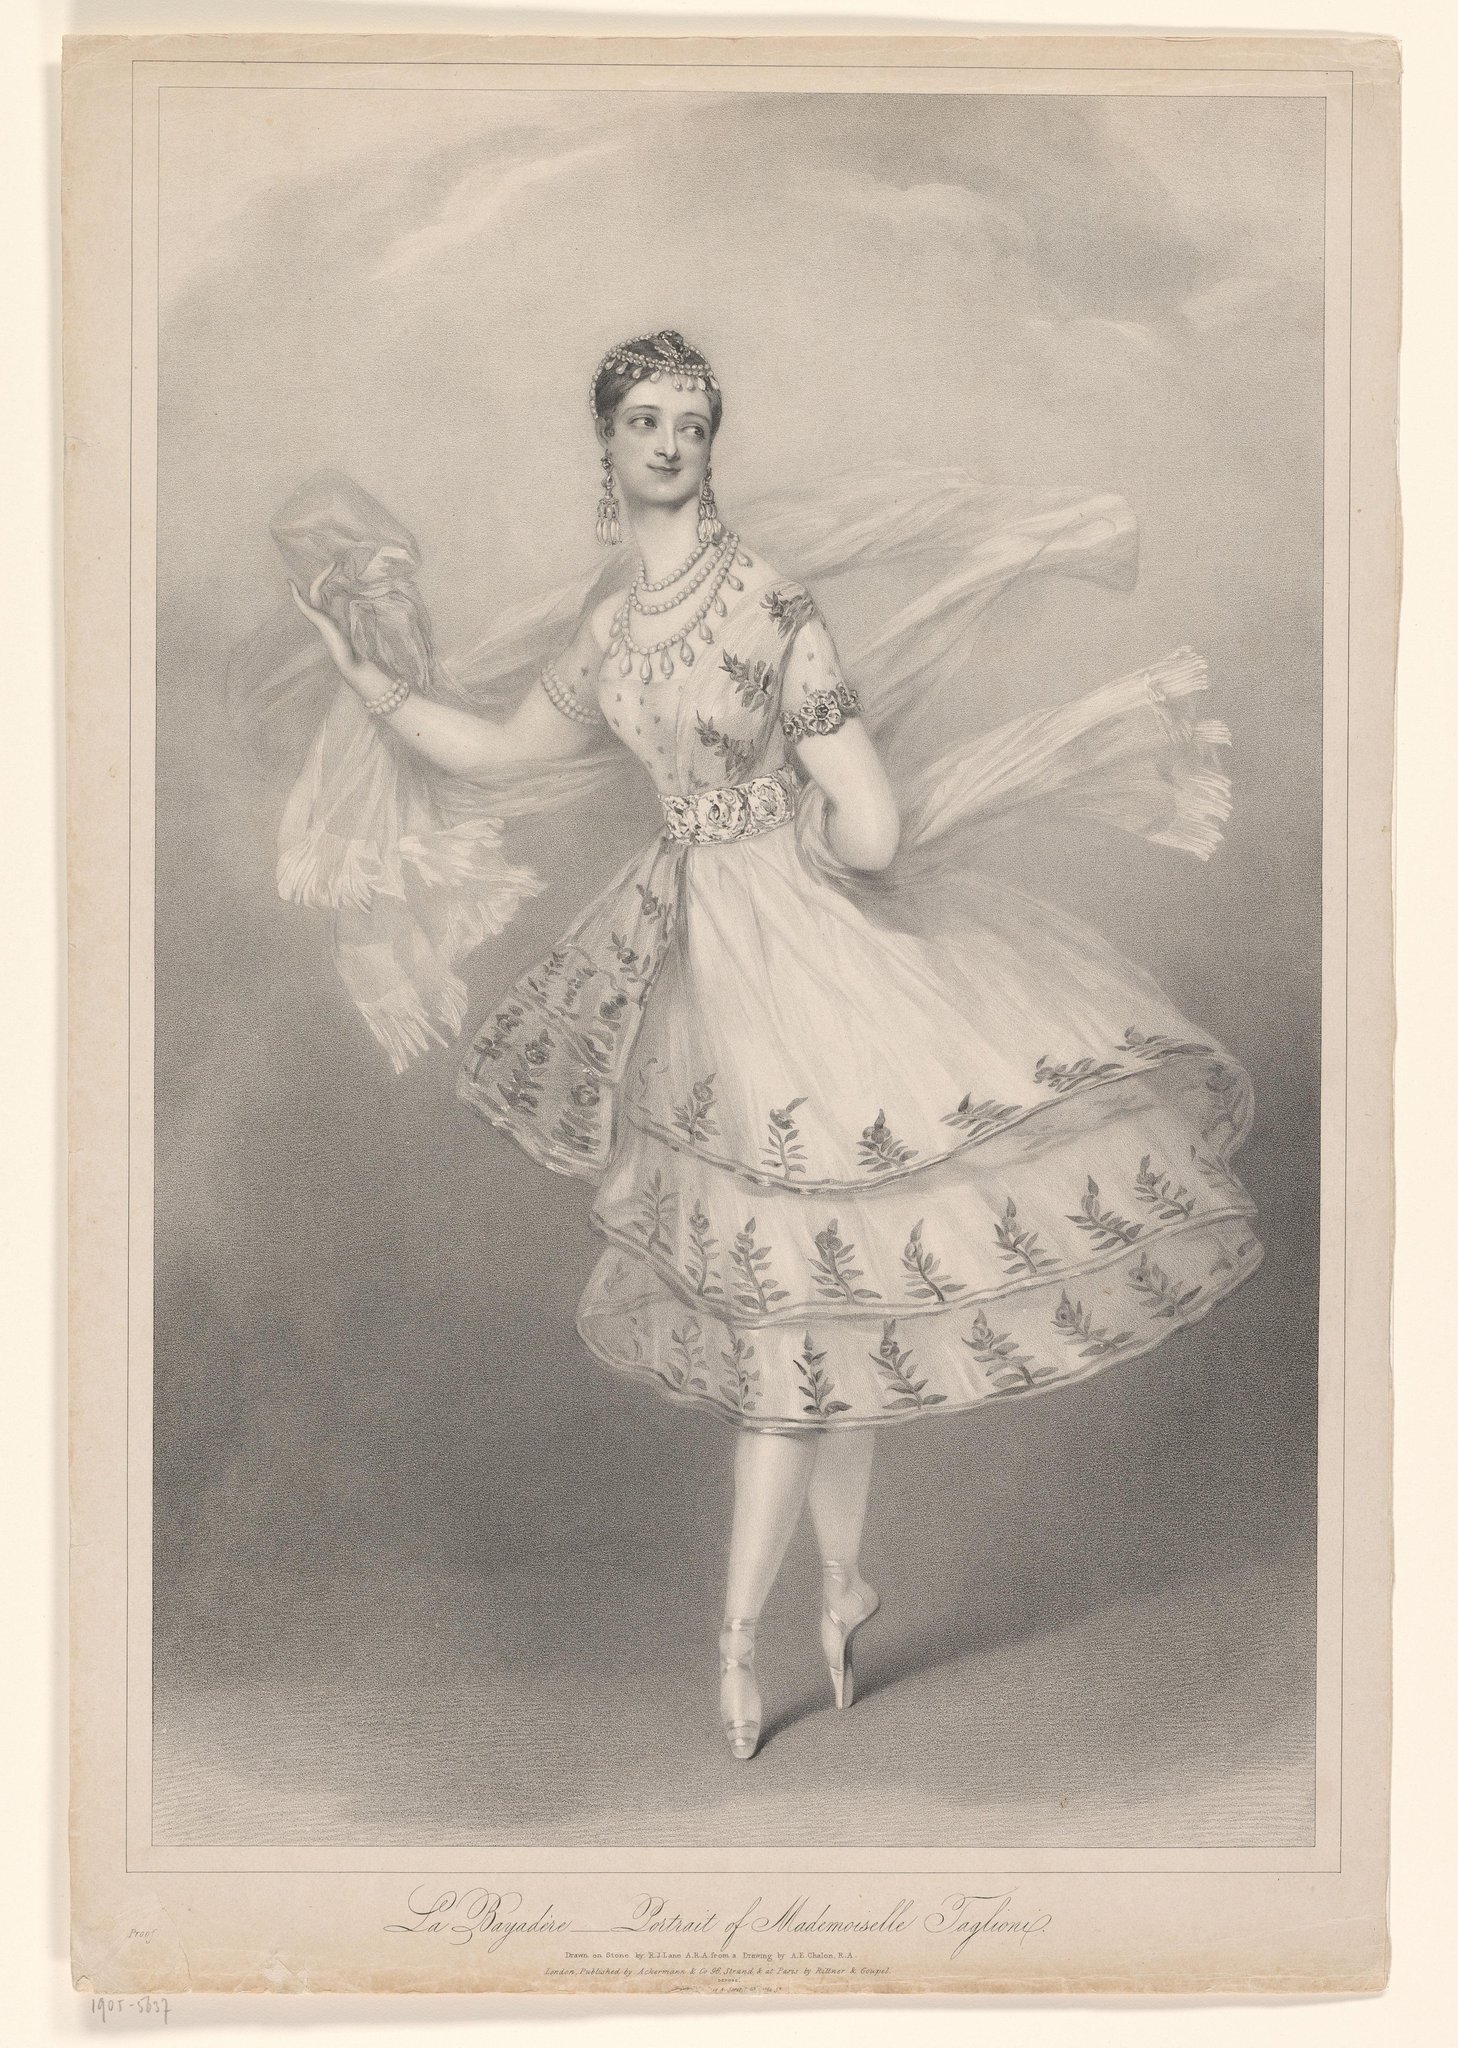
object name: print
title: Portret van Marie Taglioni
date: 1825-1835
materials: paper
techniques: lithograph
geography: paris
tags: adult woman, the ballet, ballet performance, historical persons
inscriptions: collector's mark: Lugt 2228